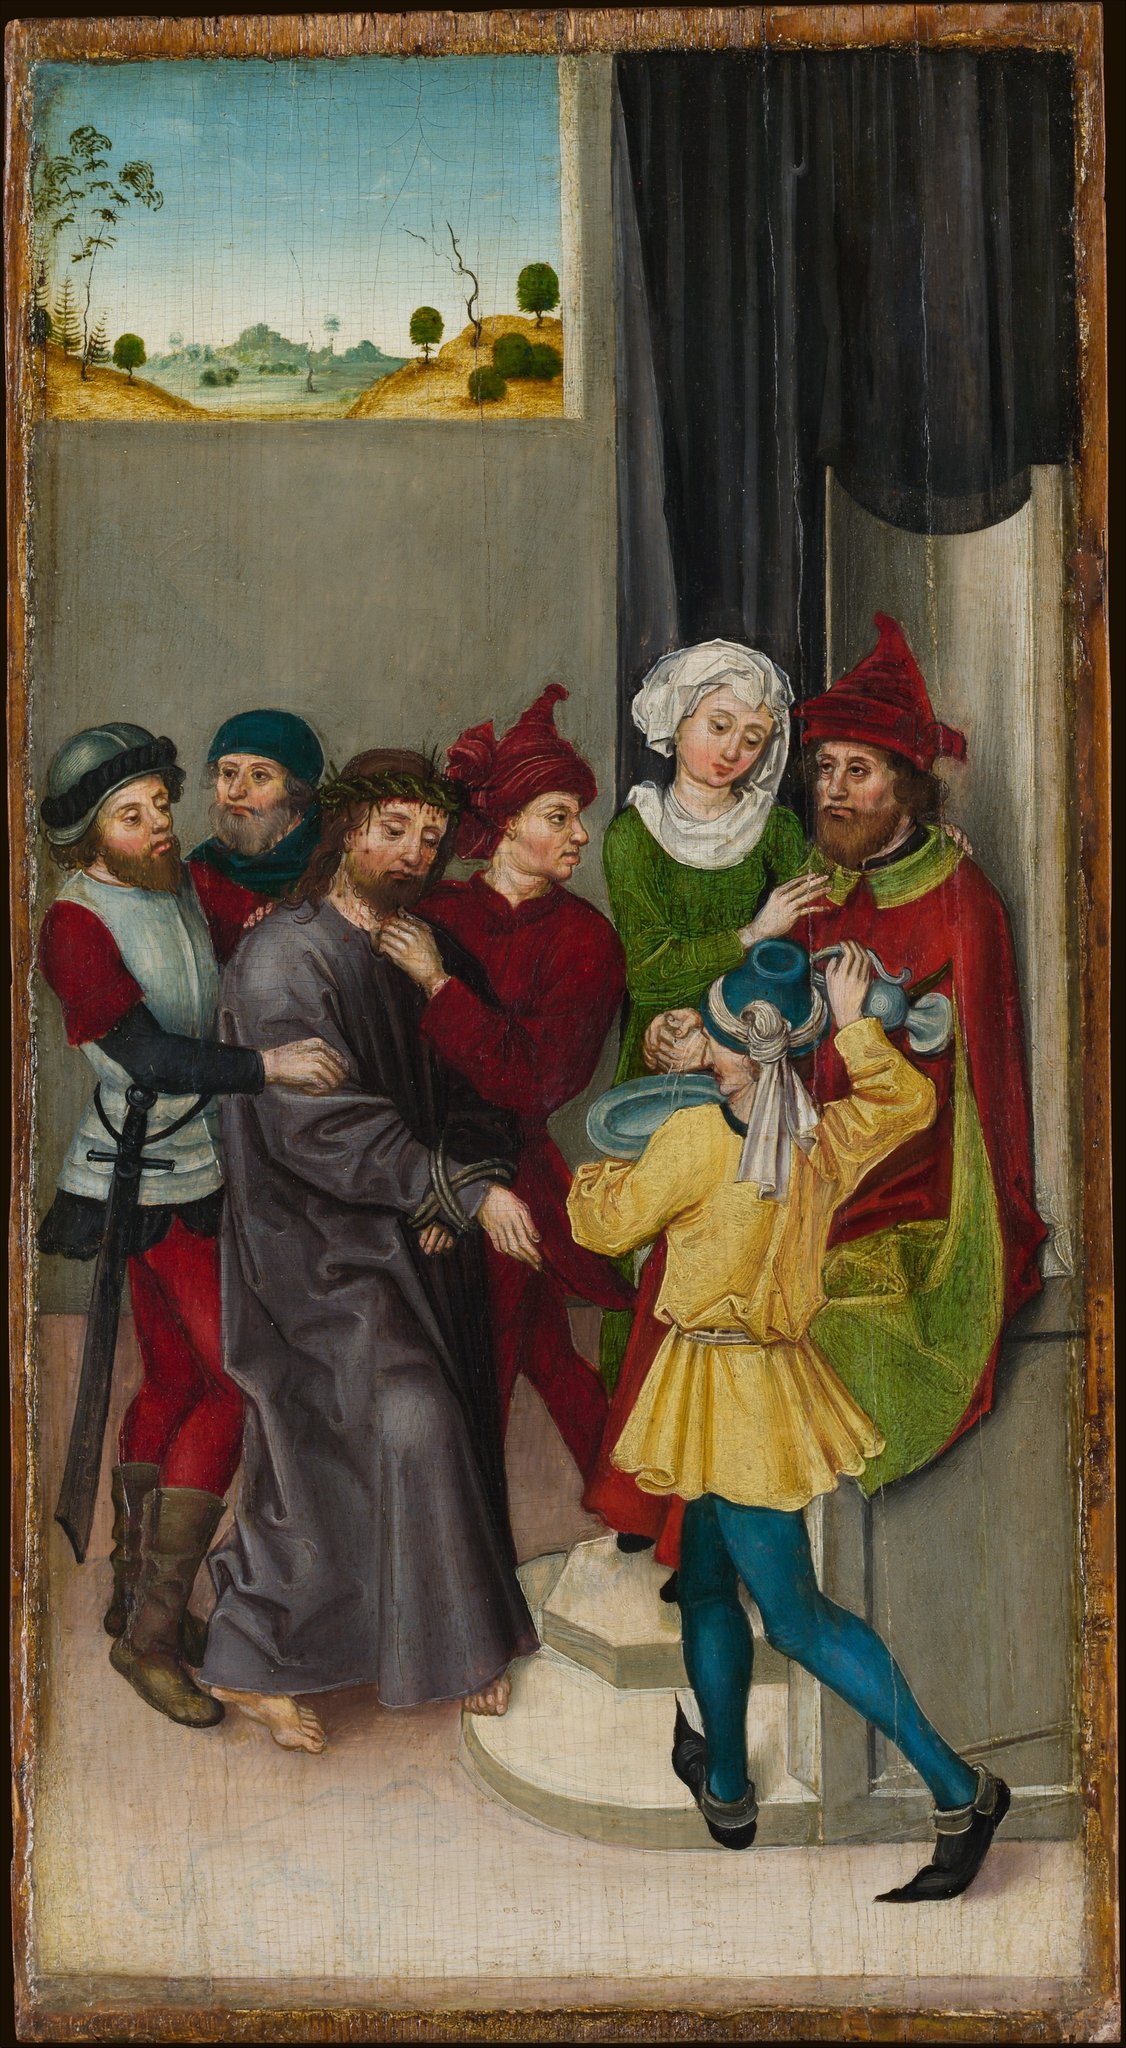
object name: painting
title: Christ before Pilate; The Resurrection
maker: ludwig schongauer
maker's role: artist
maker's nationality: german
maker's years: 1435-1494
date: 1479-1494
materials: oil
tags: soldiers,men,women,christ,pilate